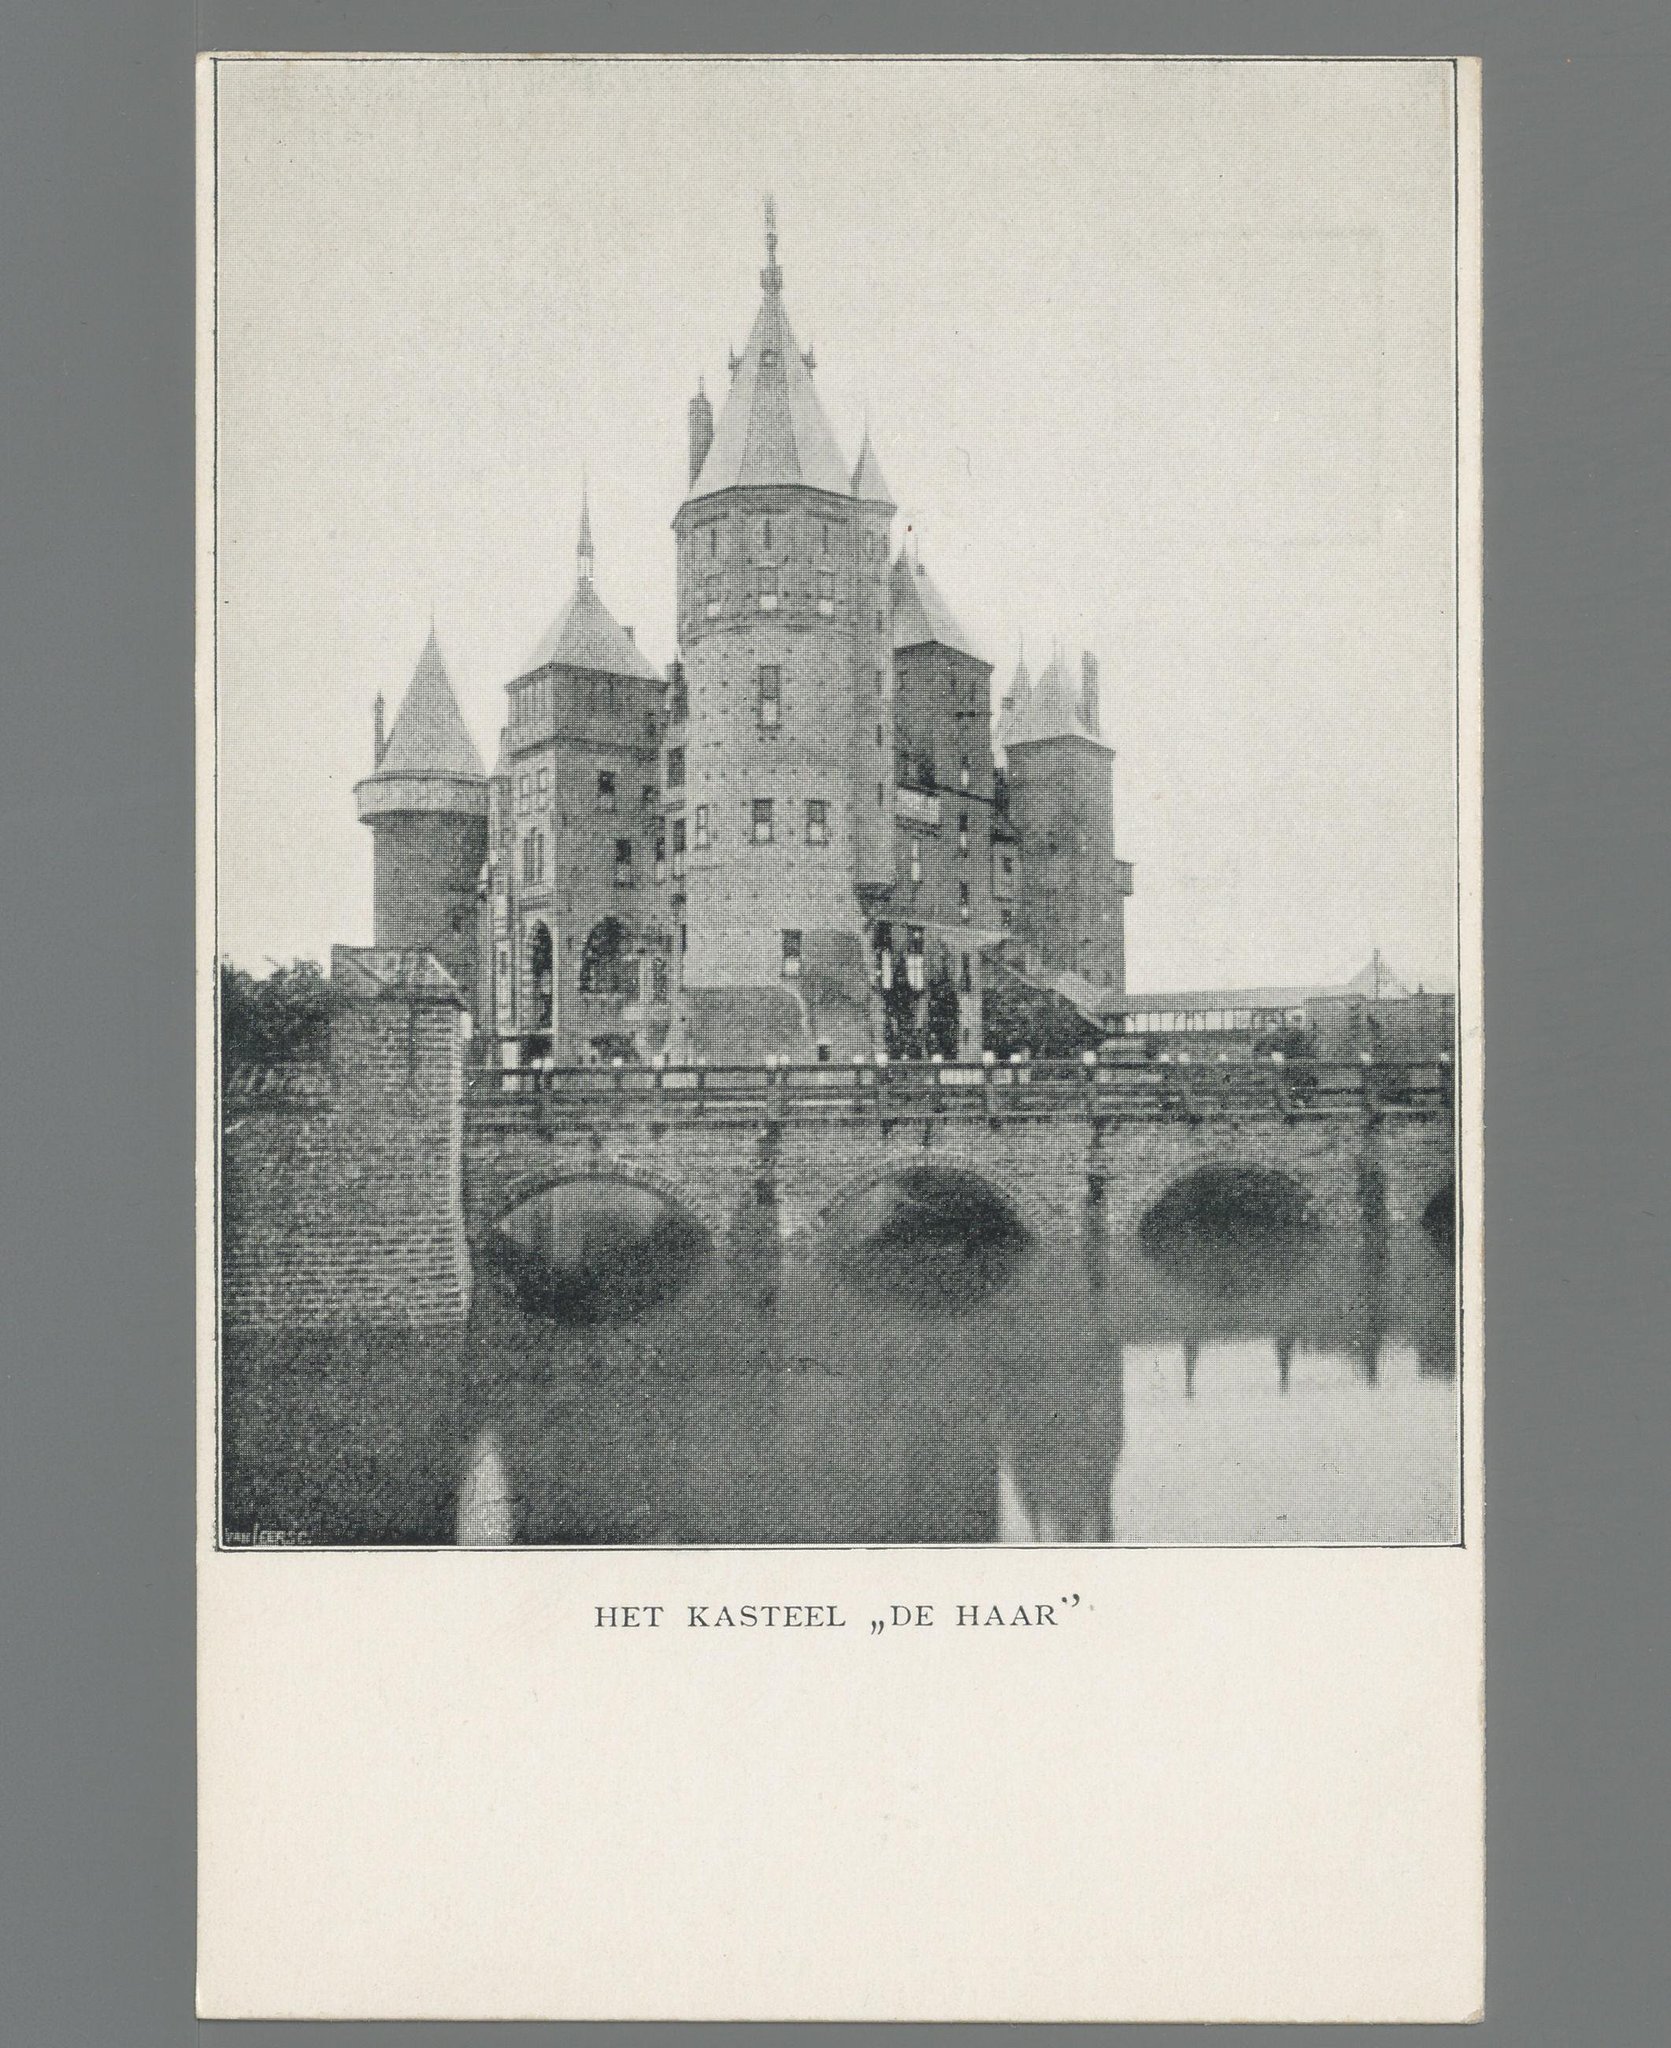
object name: photomechanical print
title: Het kasteel "De Haar"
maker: van leerse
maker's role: printer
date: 1892-1905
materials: cardboard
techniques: autotype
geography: haarzuilens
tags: castle, canal